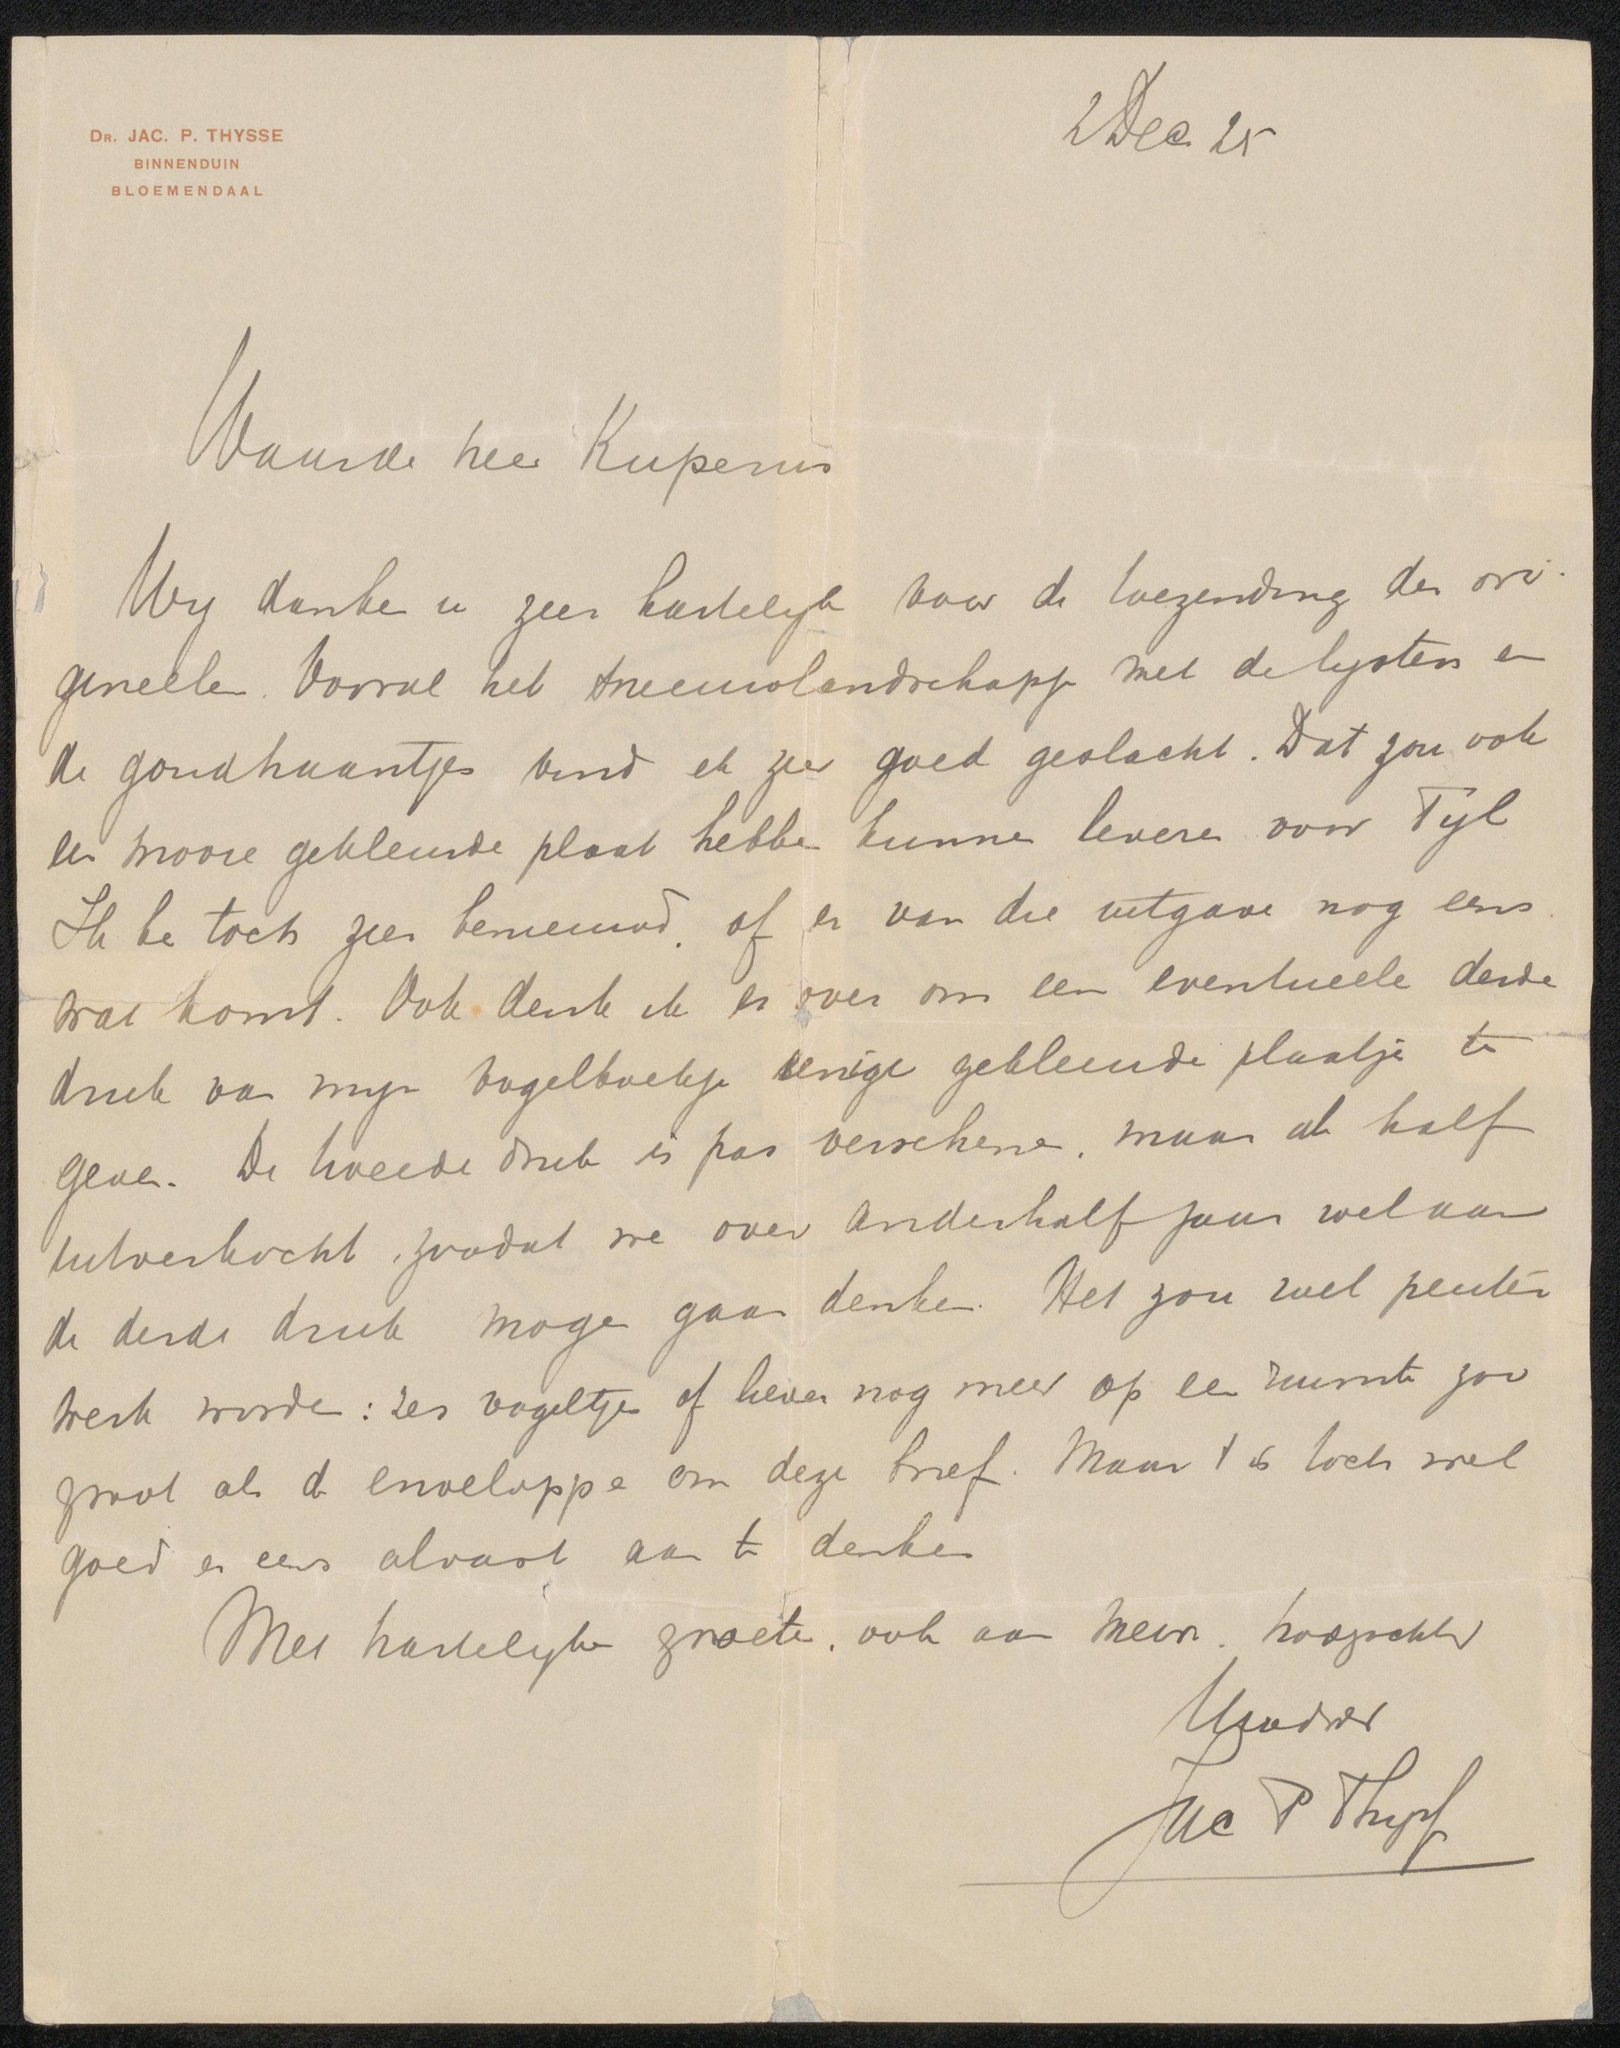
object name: letter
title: Brief aan Sjoerd Kuperus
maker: jac. p. thijsse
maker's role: bioloog, onderwijzer, schrijver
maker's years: 1865-1945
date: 1925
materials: ink, paper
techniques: pen, printing, writing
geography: bloemendaal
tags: print maker, sjoerd kuperus, illustration ~ printed matter, book, printed matter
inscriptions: collector's mark: ‘RPK’, watermark